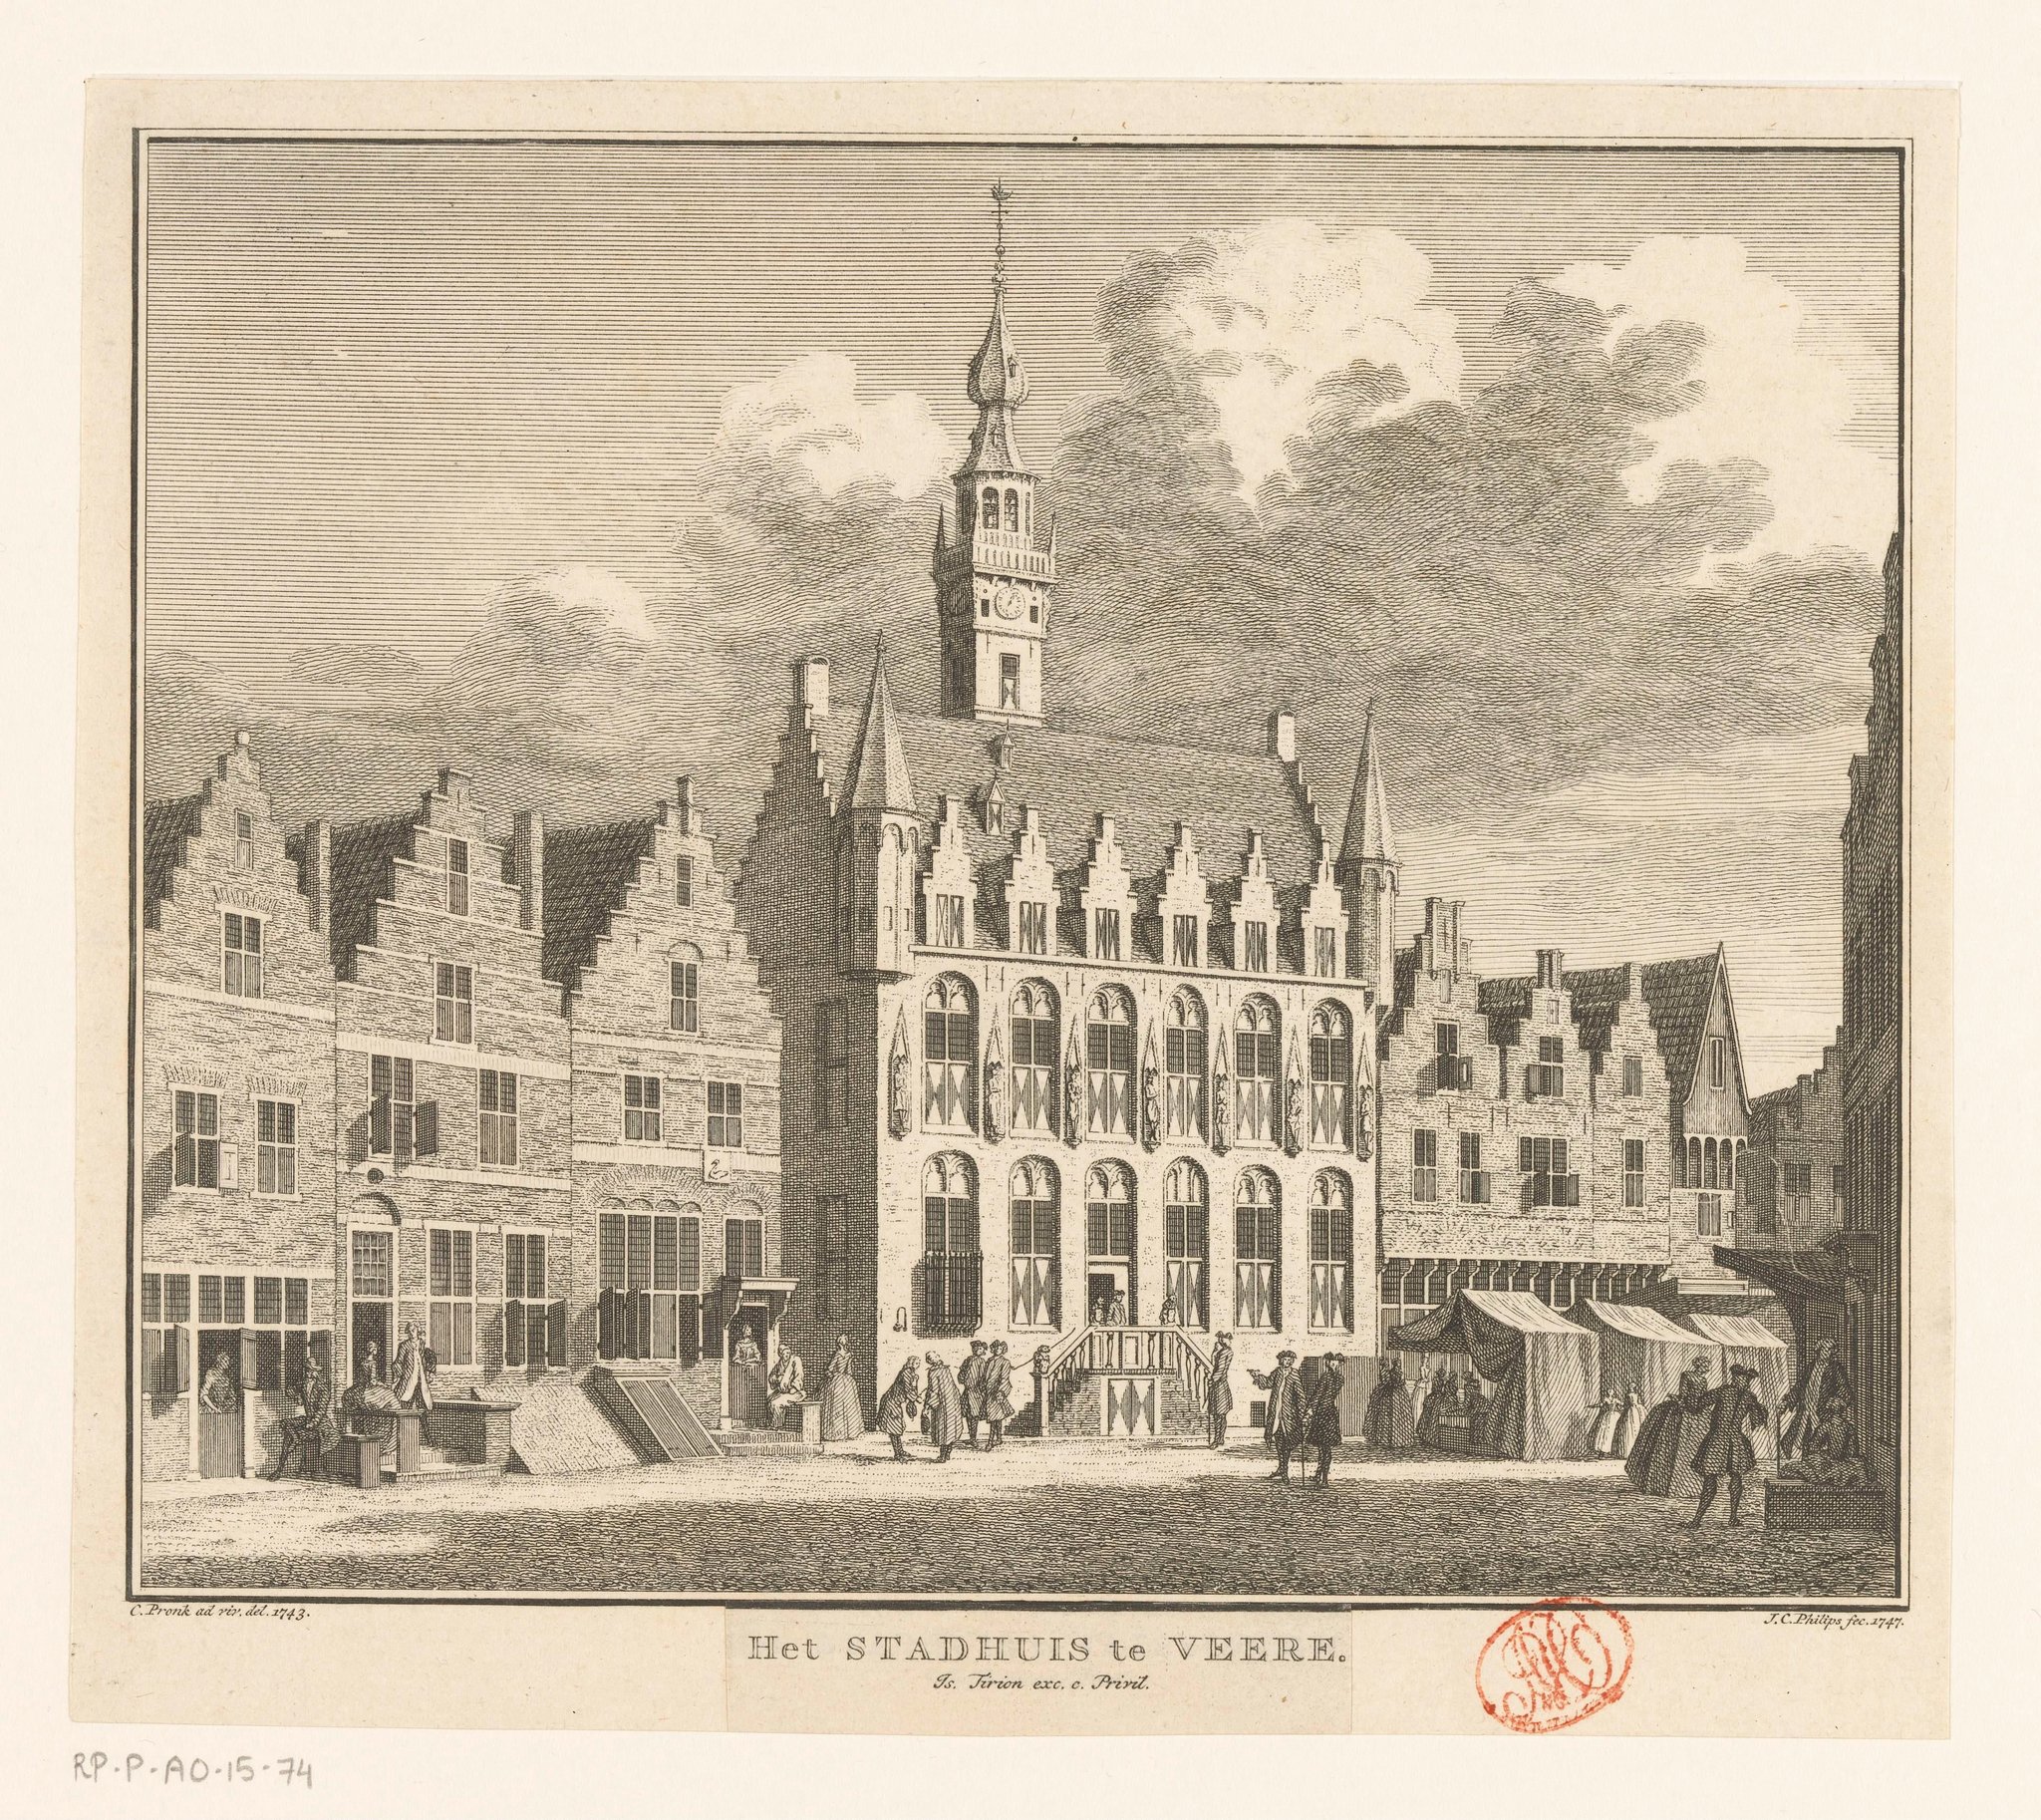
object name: book illustration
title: Gezicht op het stadhuis van Veere, 1743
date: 1747-1760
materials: paper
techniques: etching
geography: amsterdam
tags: townhall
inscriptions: collector's mark: Lugt 195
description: Gezicht op het stadhuis van Veere, in de situatie omstreeks 1743.